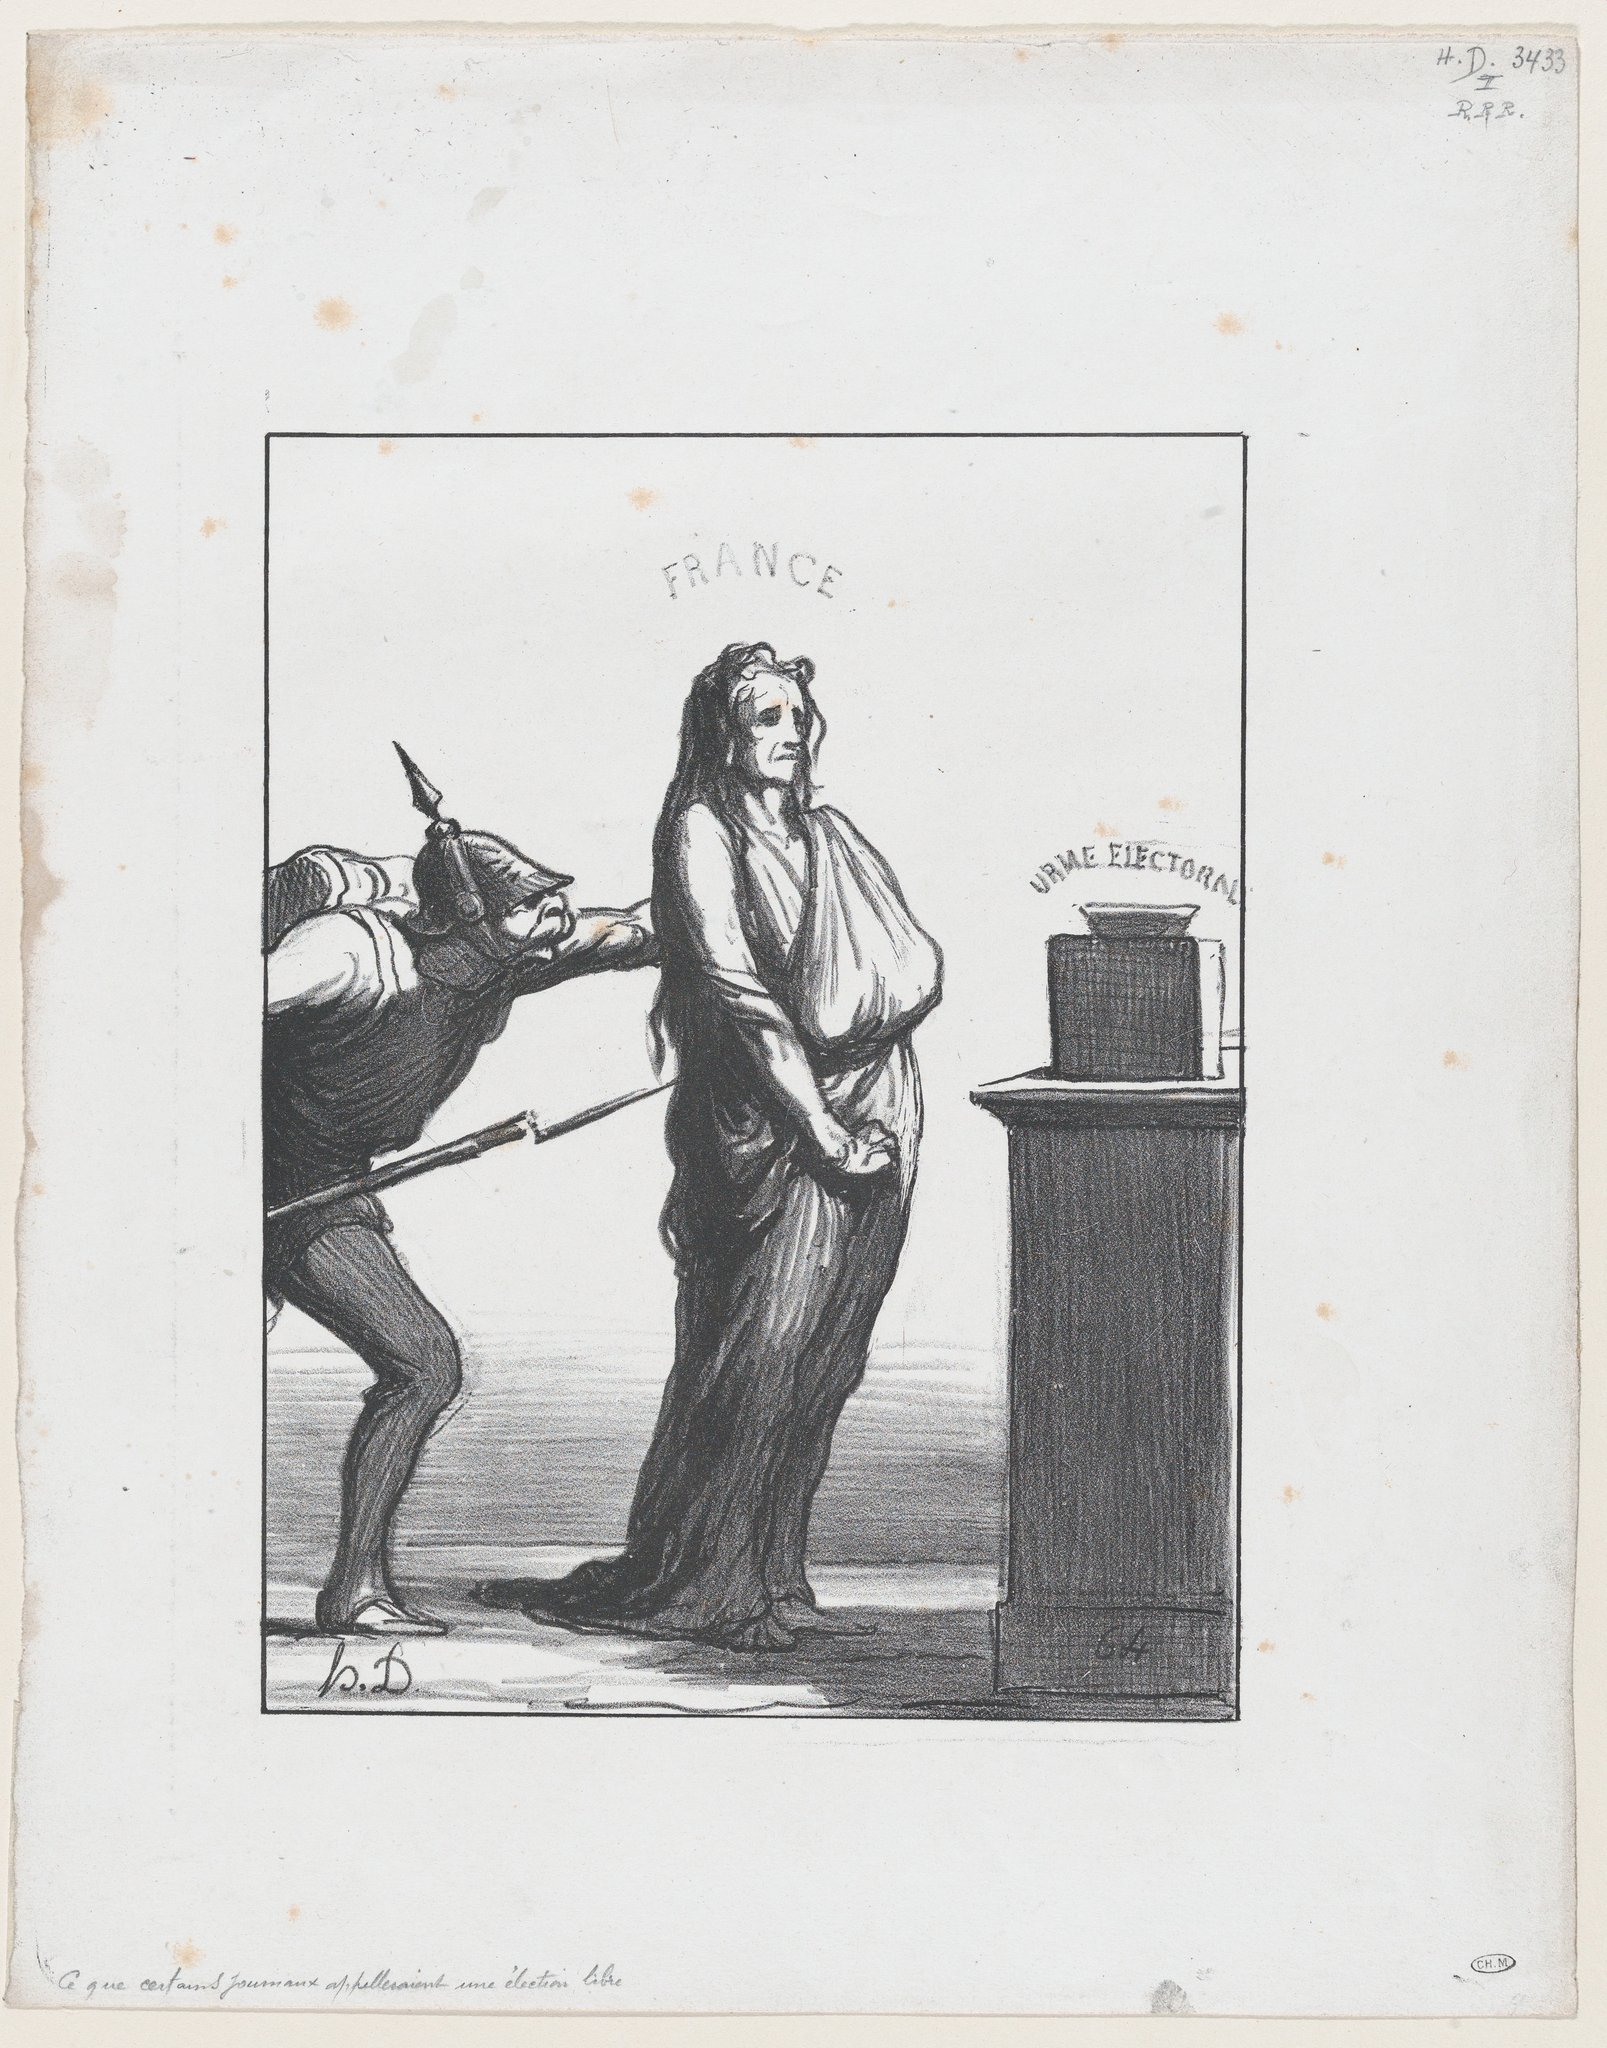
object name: print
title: What certain newspapers would call a free election, from 'News of the day'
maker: honoré daumier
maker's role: artist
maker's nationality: french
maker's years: 1808-1879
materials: paper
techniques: lithograph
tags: soldiers,elections,men,women